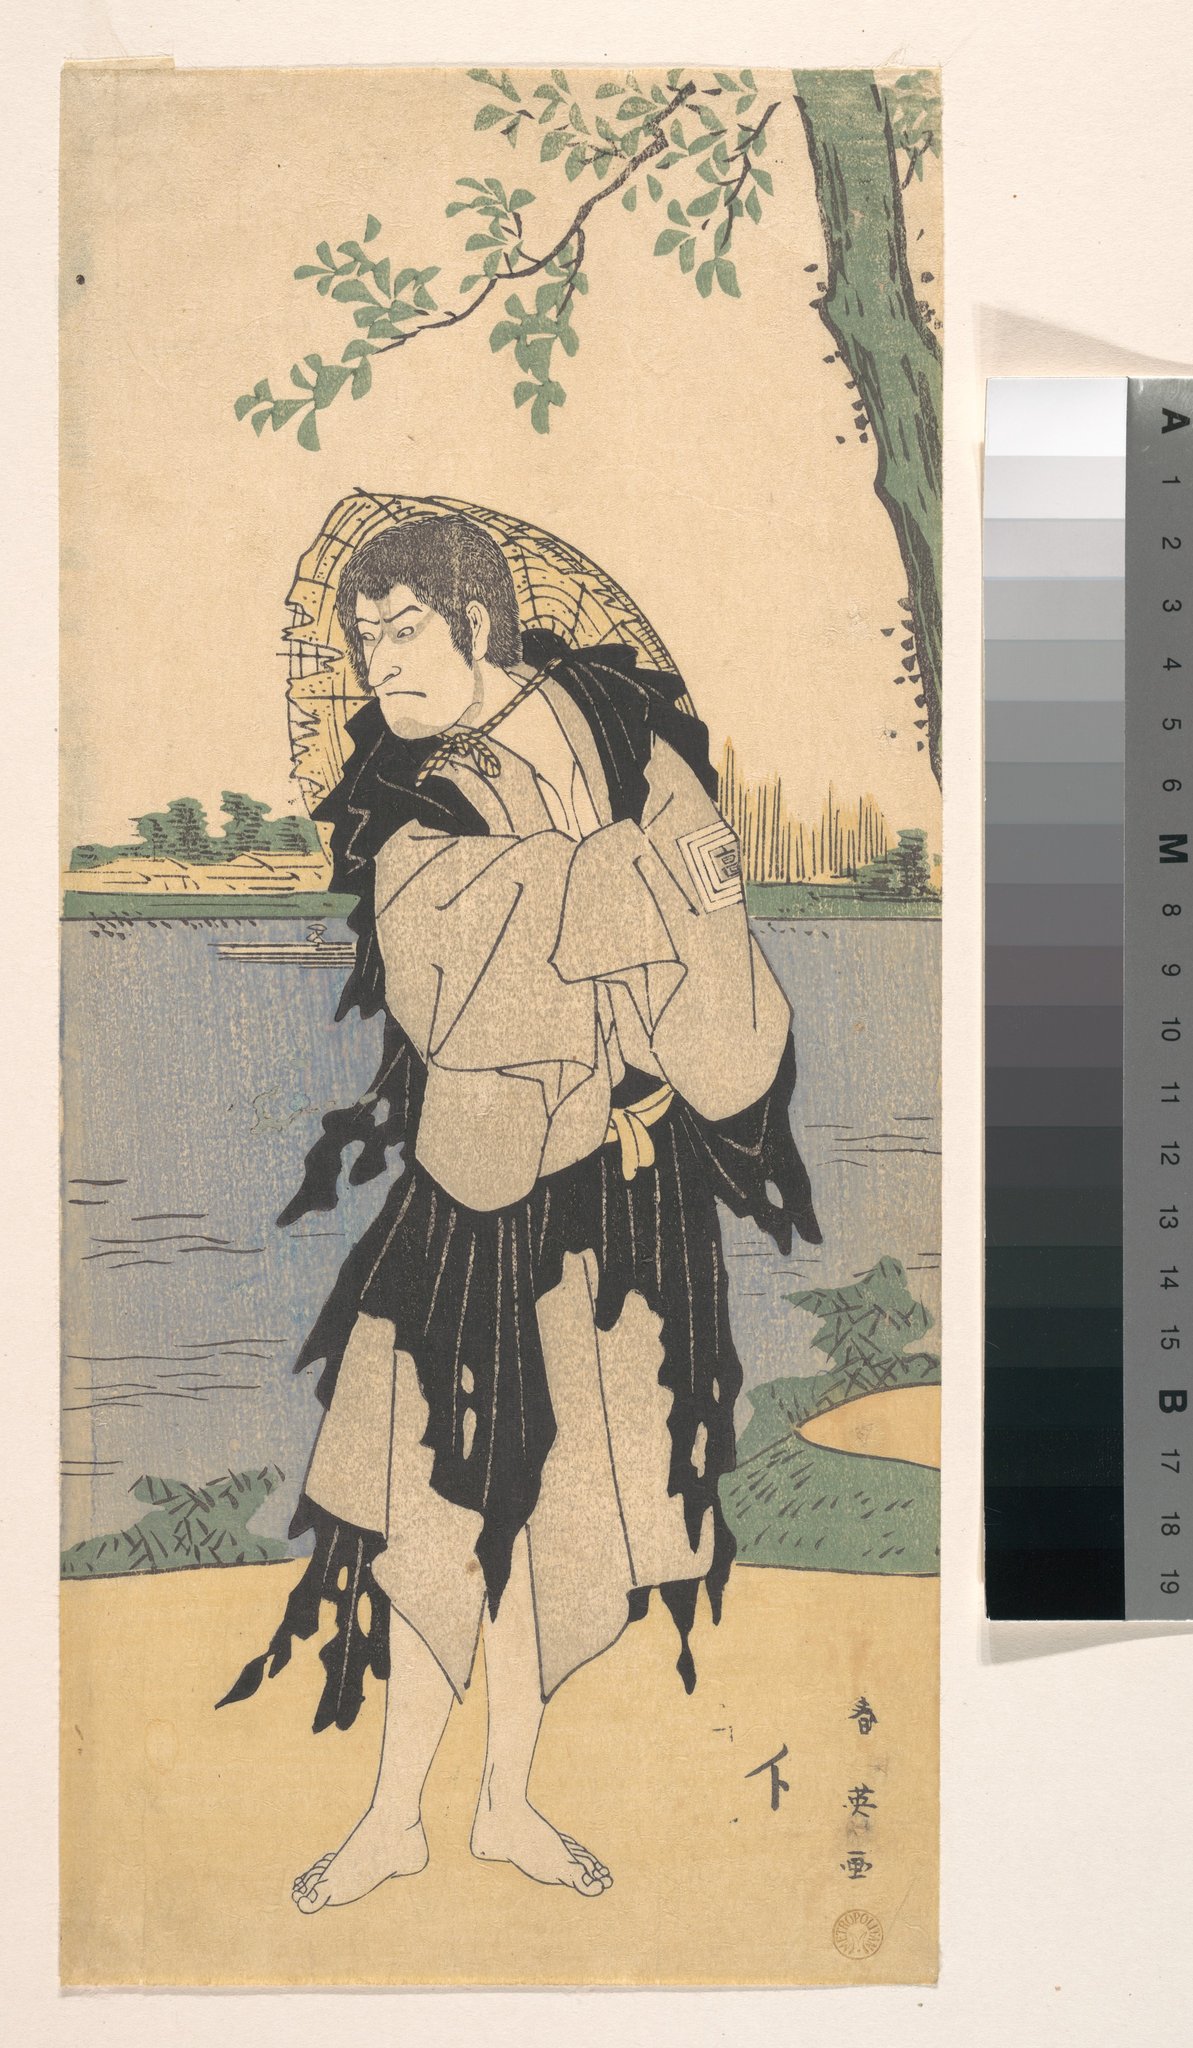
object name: print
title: The Second Ichikawa Komazo in the Role of Yanekozo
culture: japanese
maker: katsukawa shun'ei 勝川春英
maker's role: artist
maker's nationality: japanese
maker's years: 1762-1819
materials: ink, paper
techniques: woodblock print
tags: trees,actors